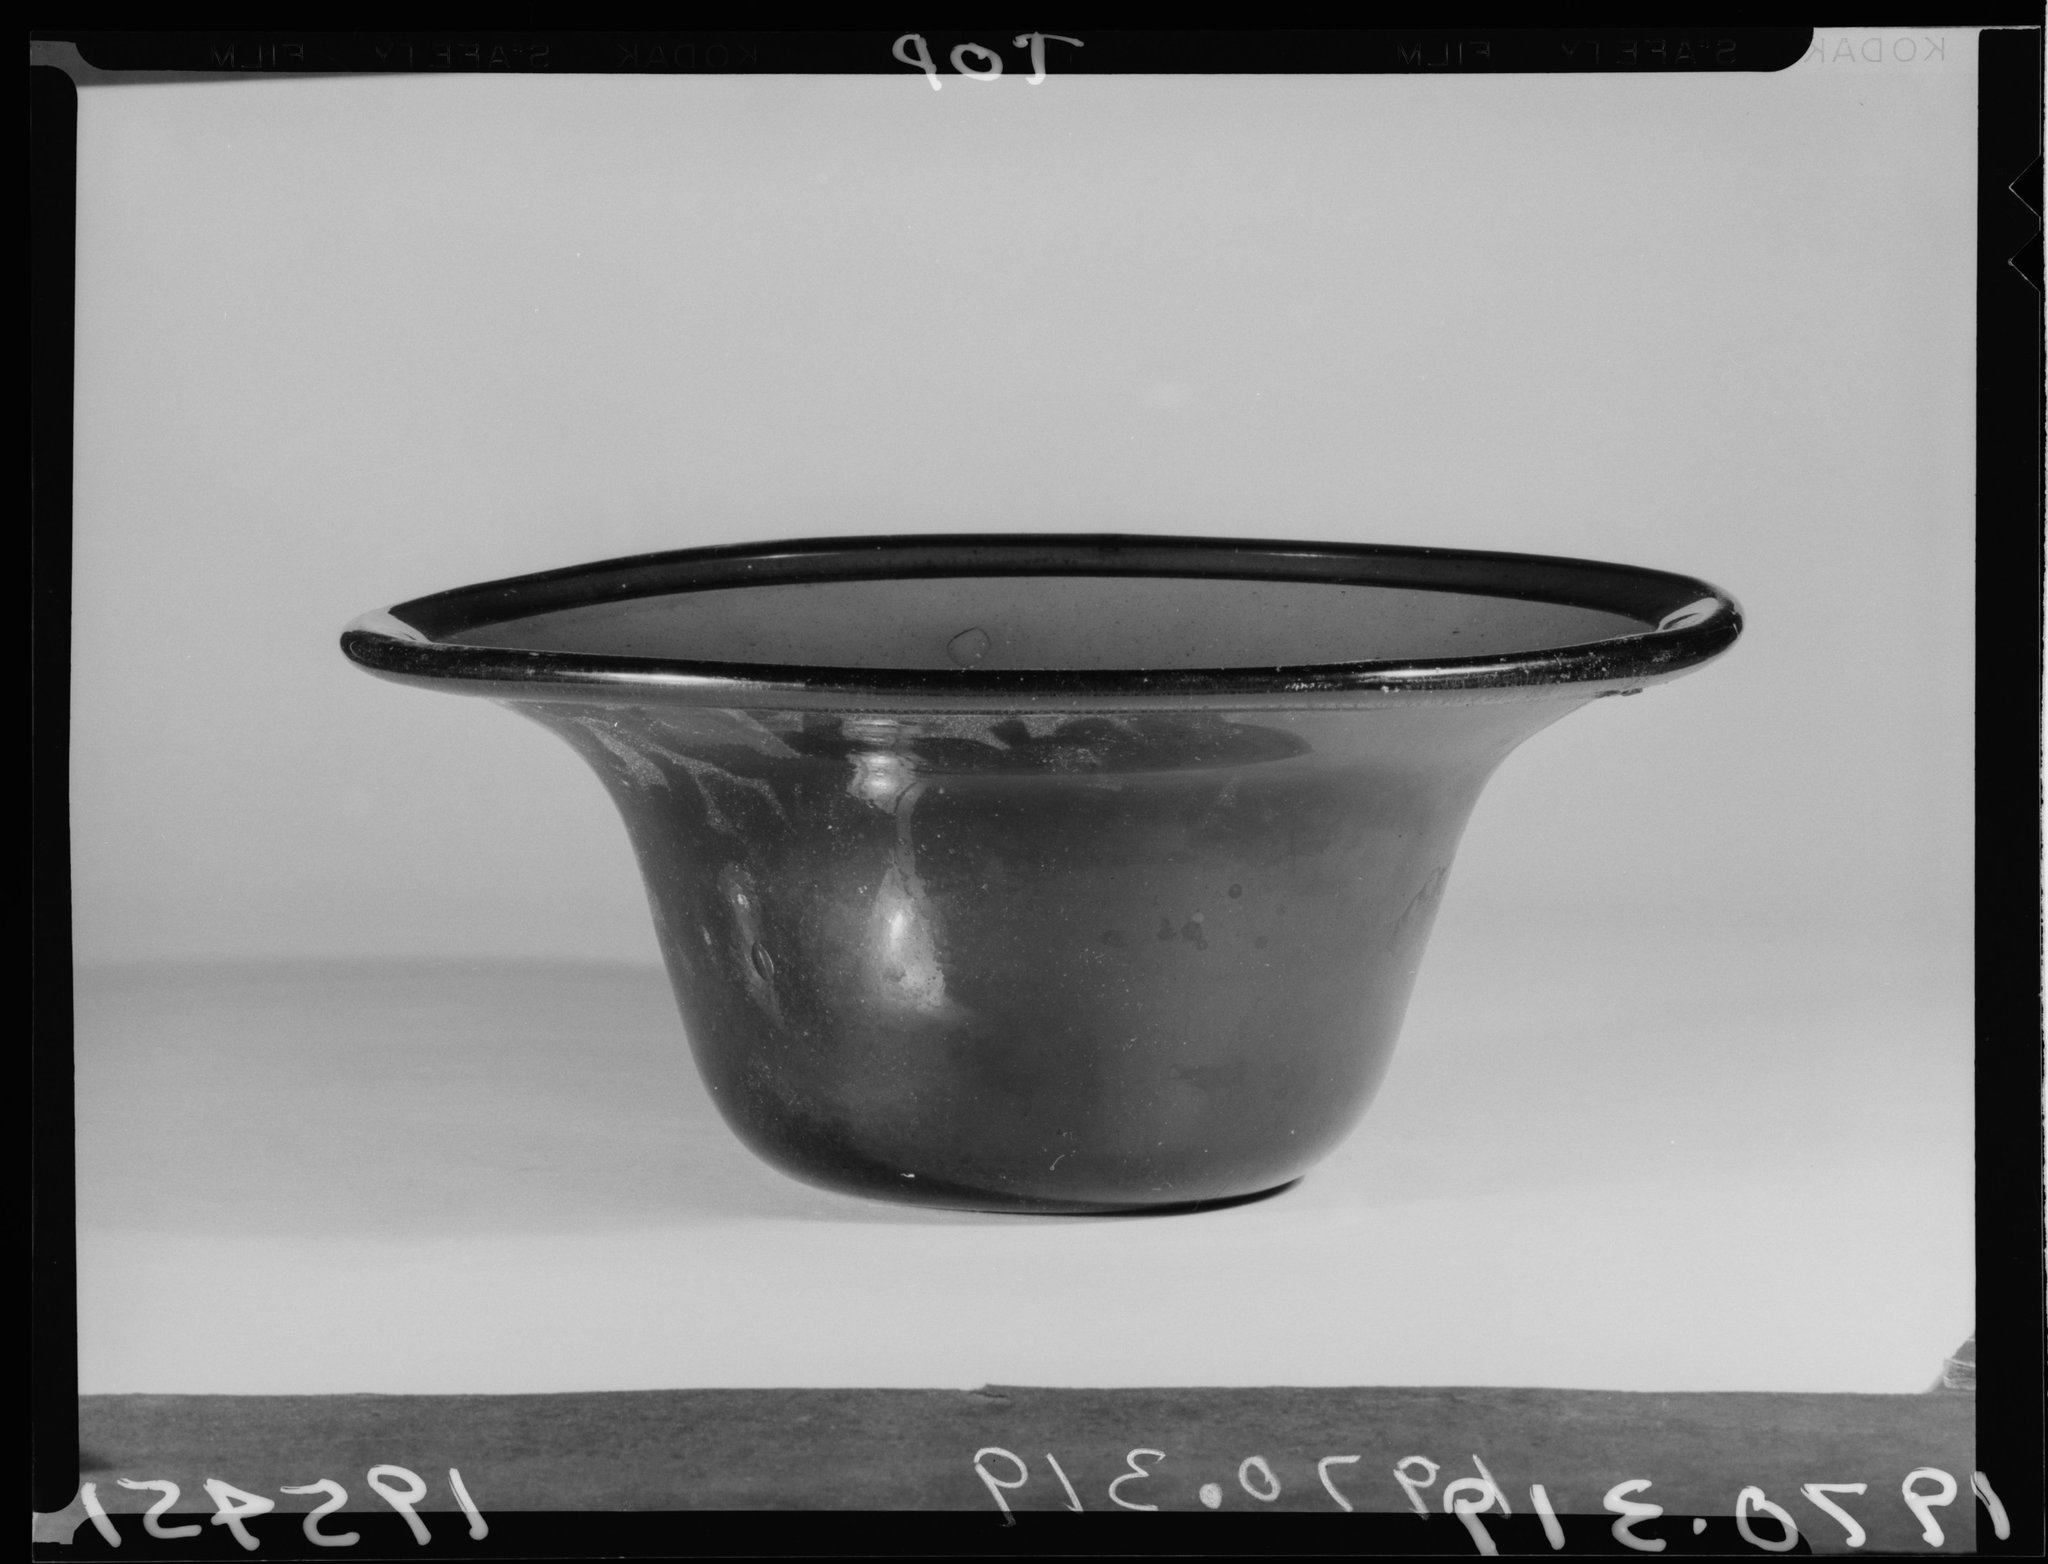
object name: milk bowl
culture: american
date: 1810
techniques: glassblowing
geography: united states